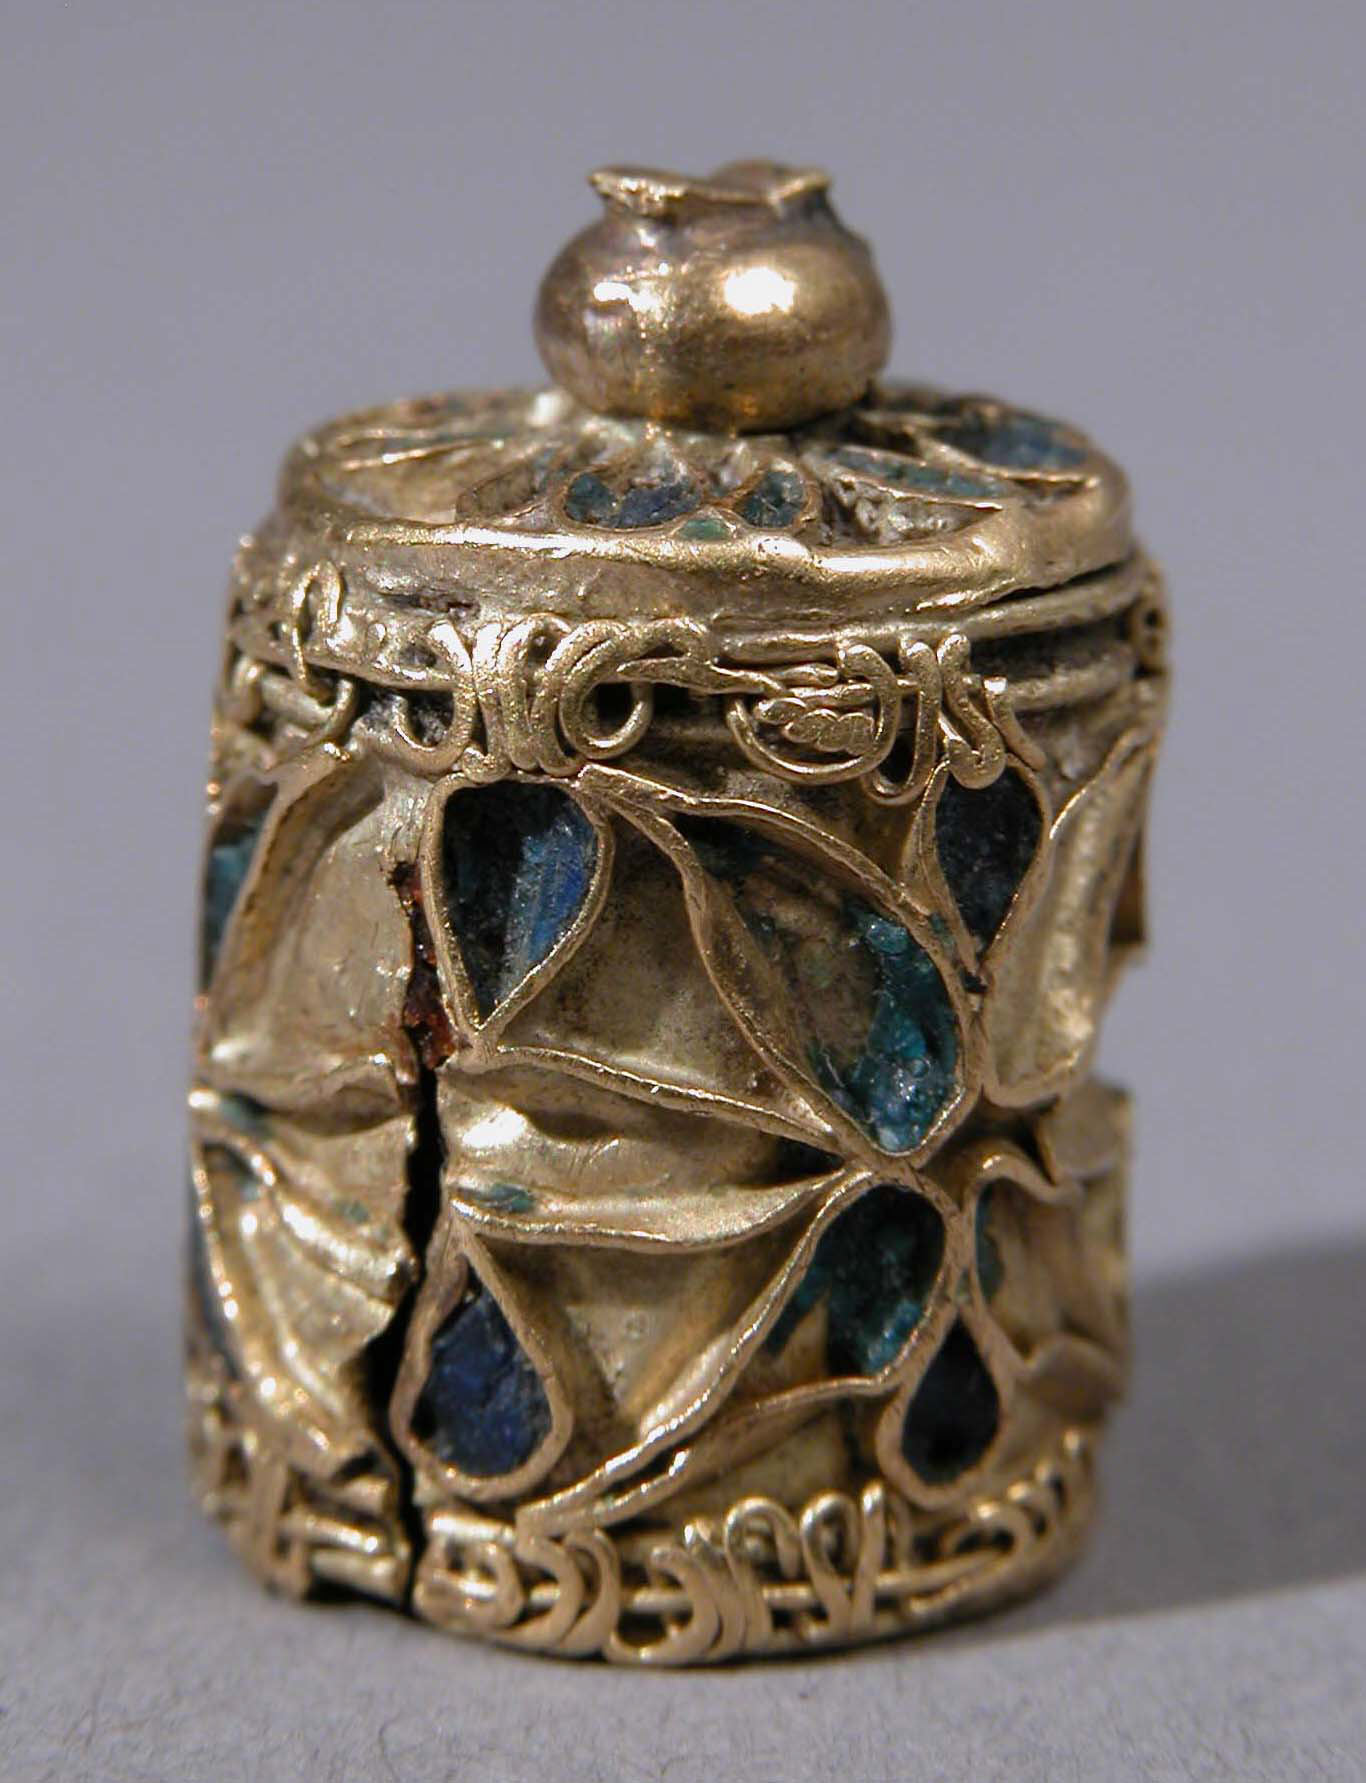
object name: reliquary finial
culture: byzantine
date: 801-1000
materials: enamel, gold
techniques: enamel